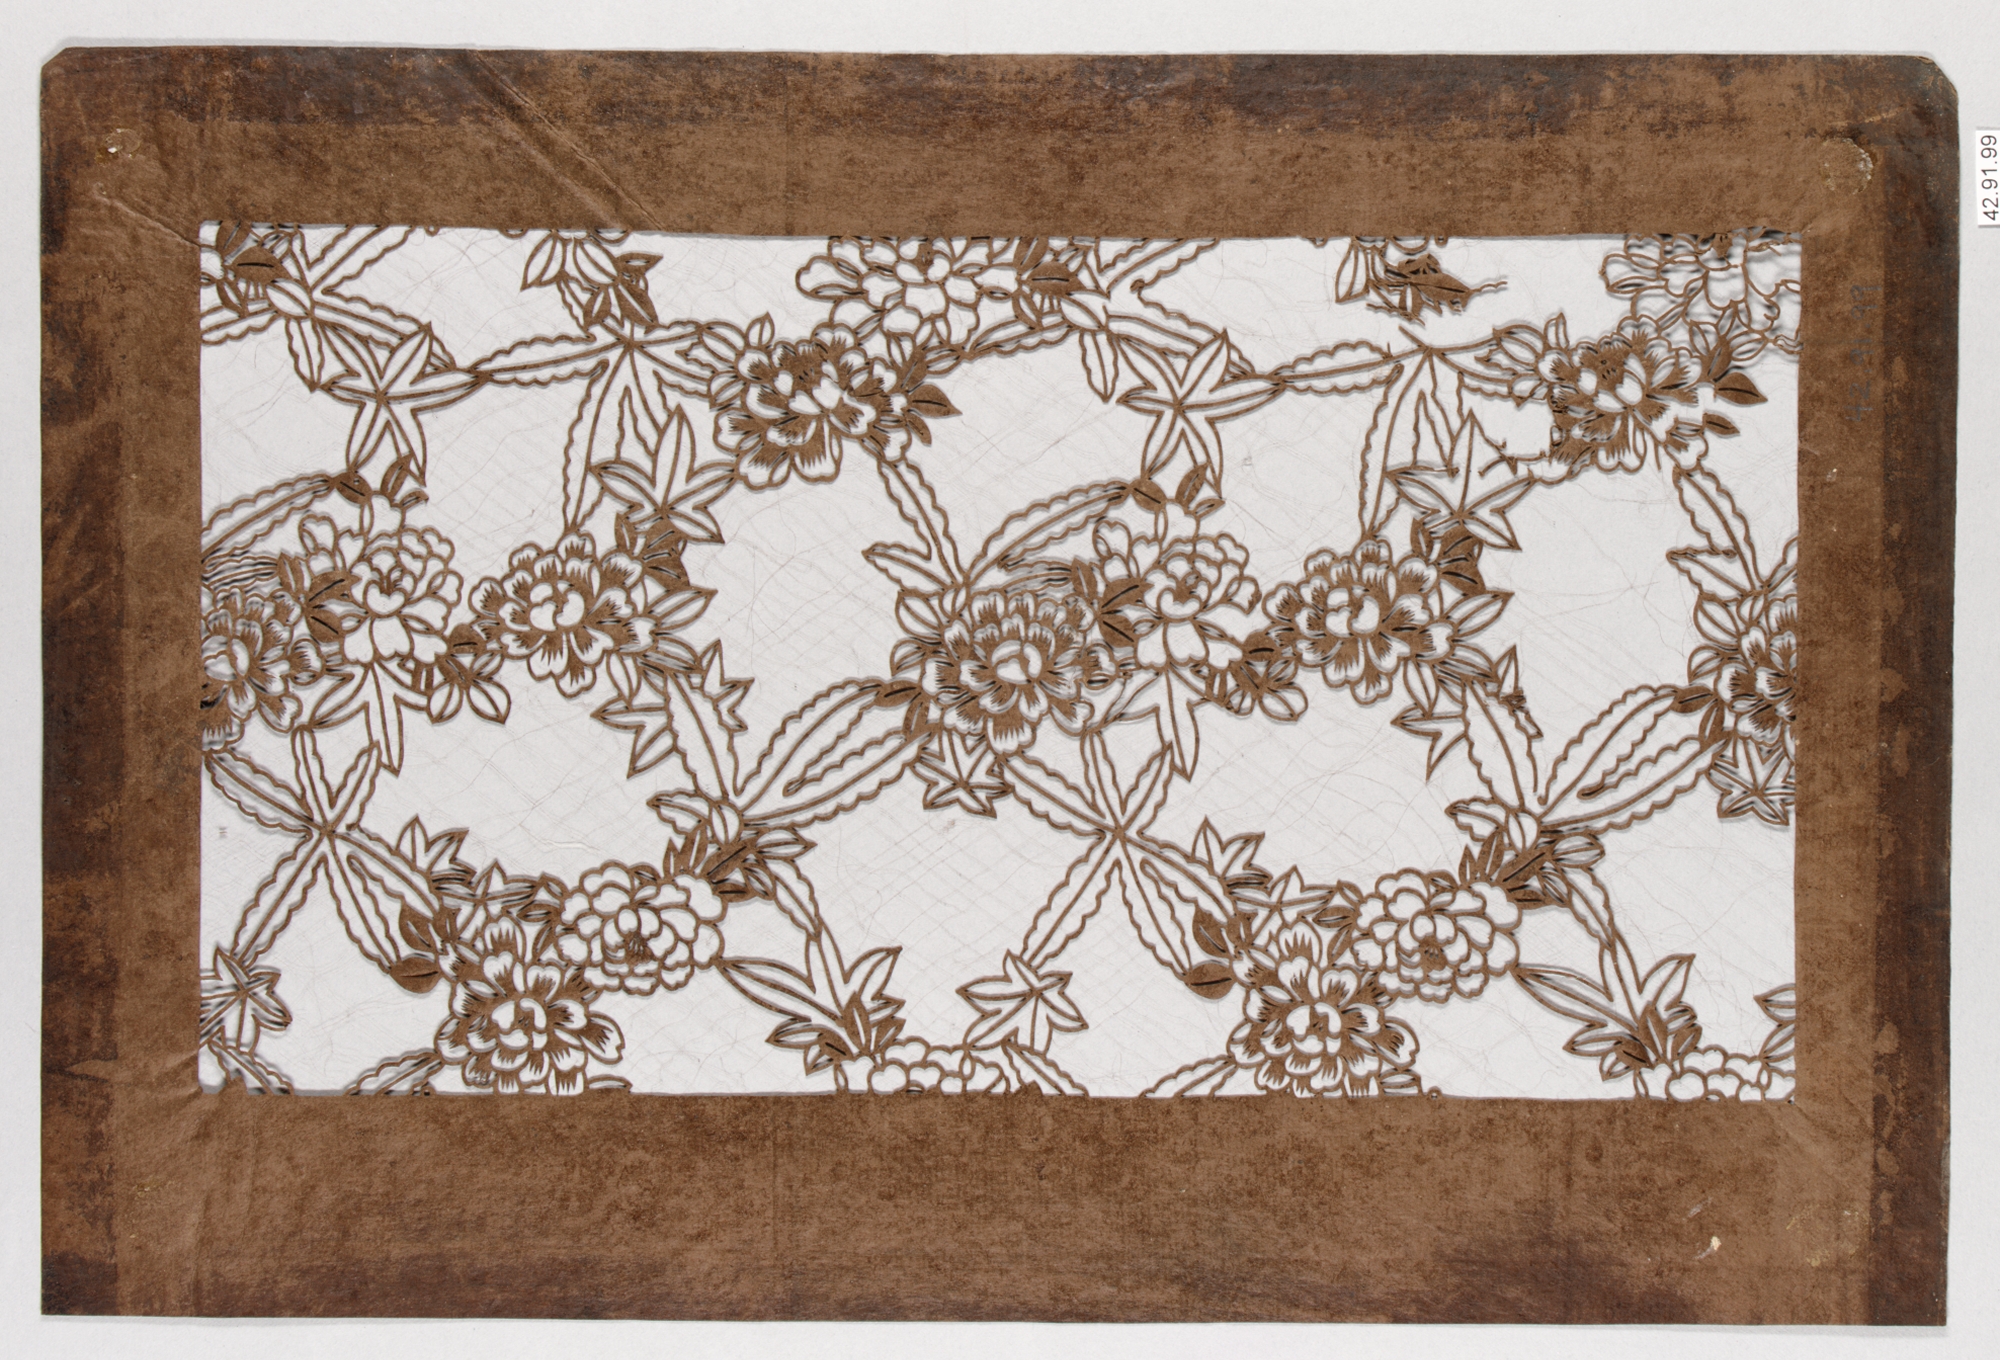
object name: stencil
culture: japanese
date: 1801-1900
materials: paper, silk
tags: flowers